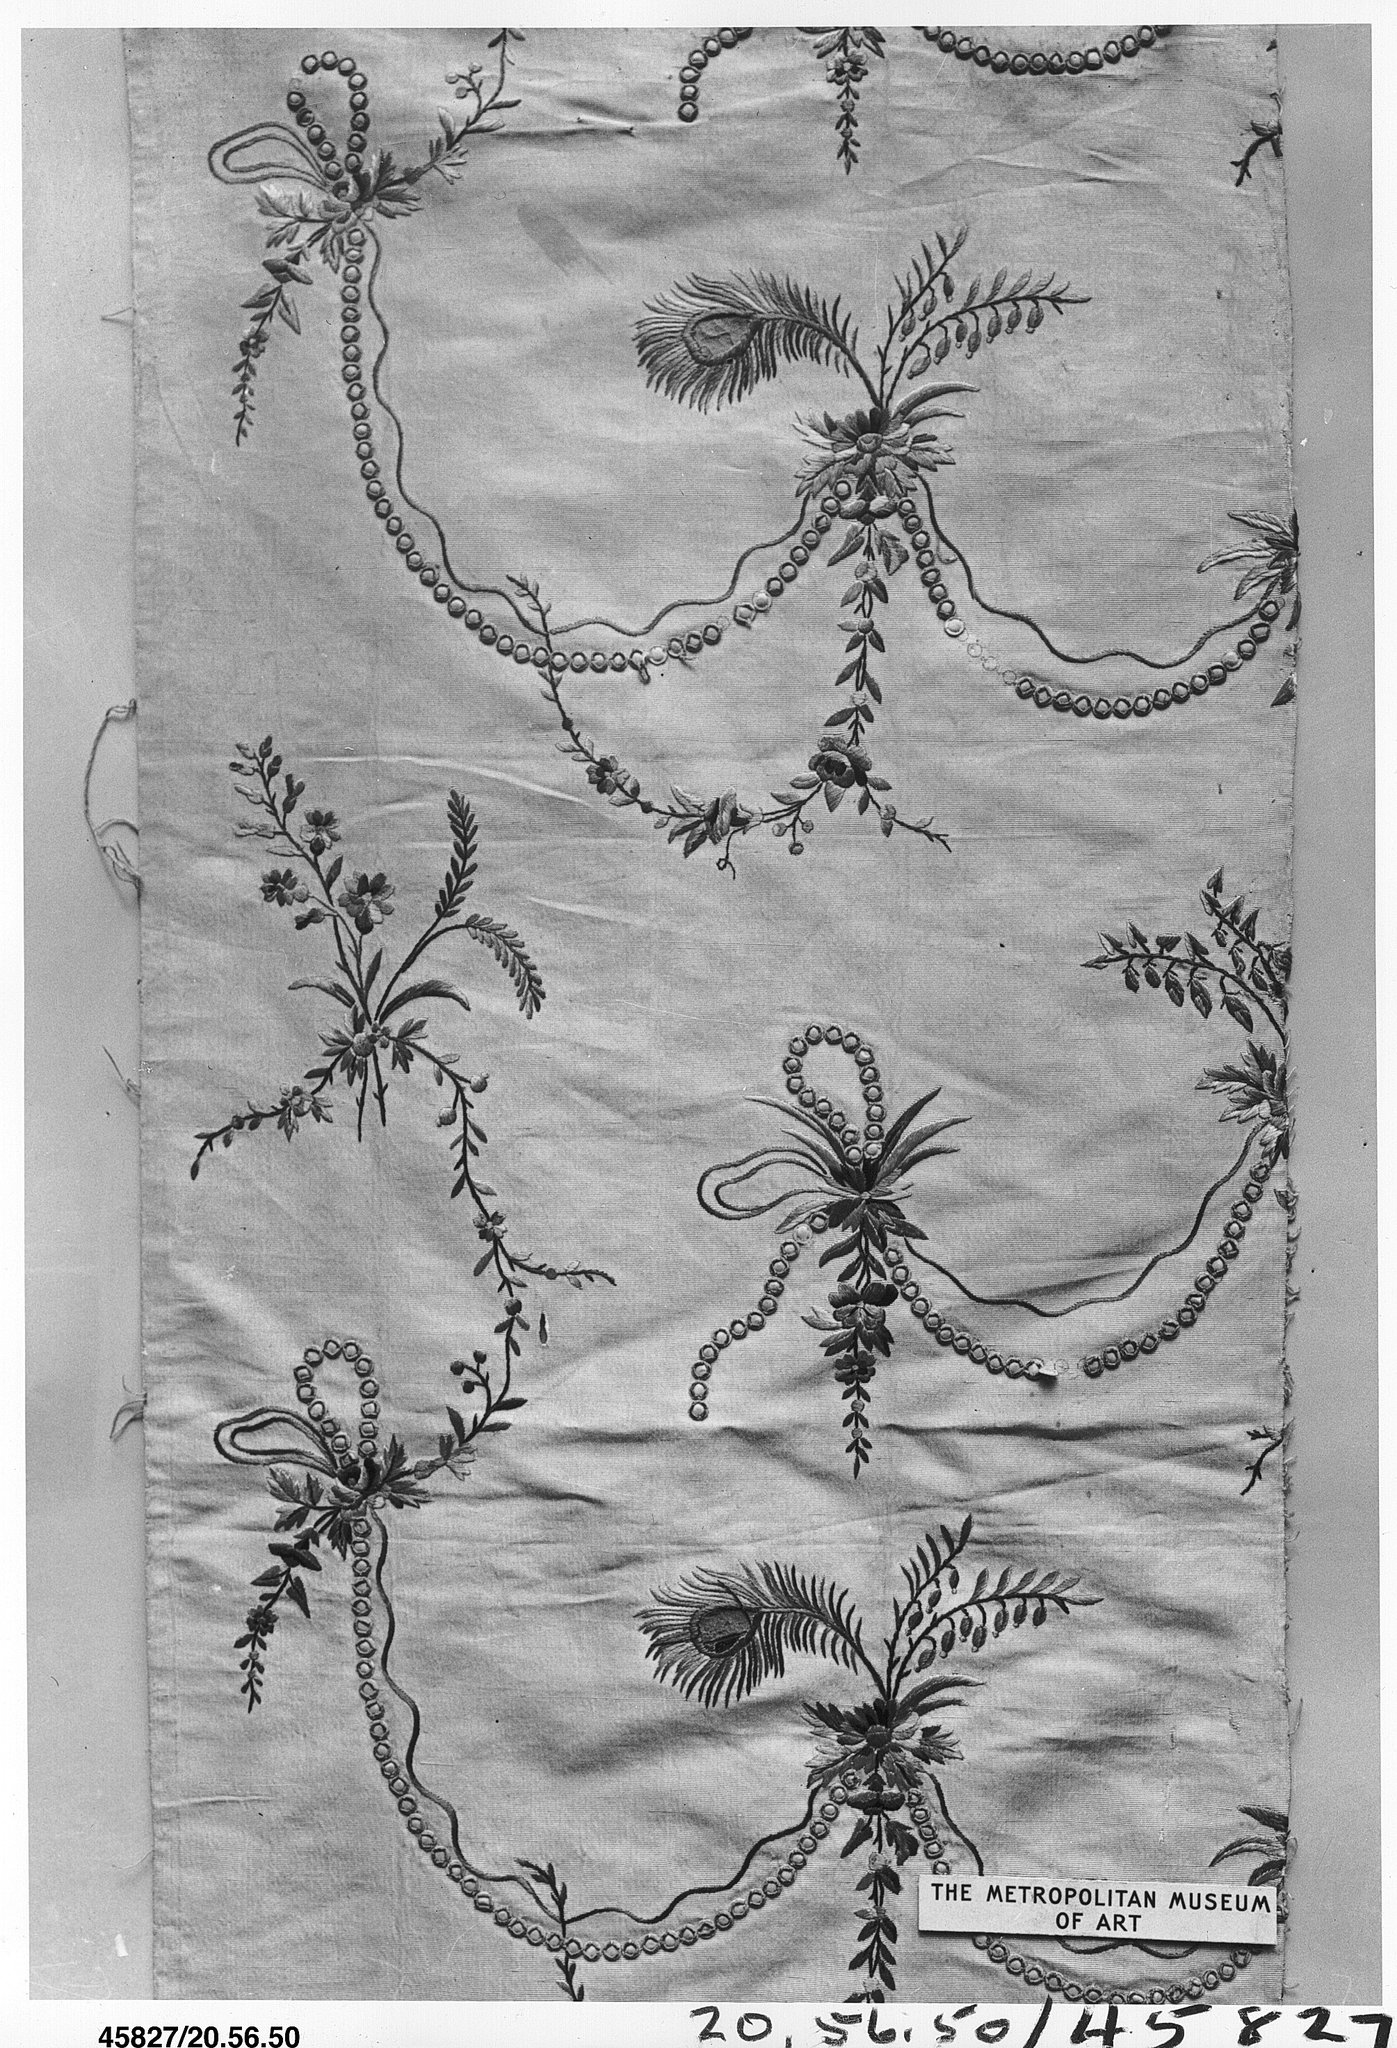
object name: piece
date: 1774-1792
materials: silk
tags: leaves